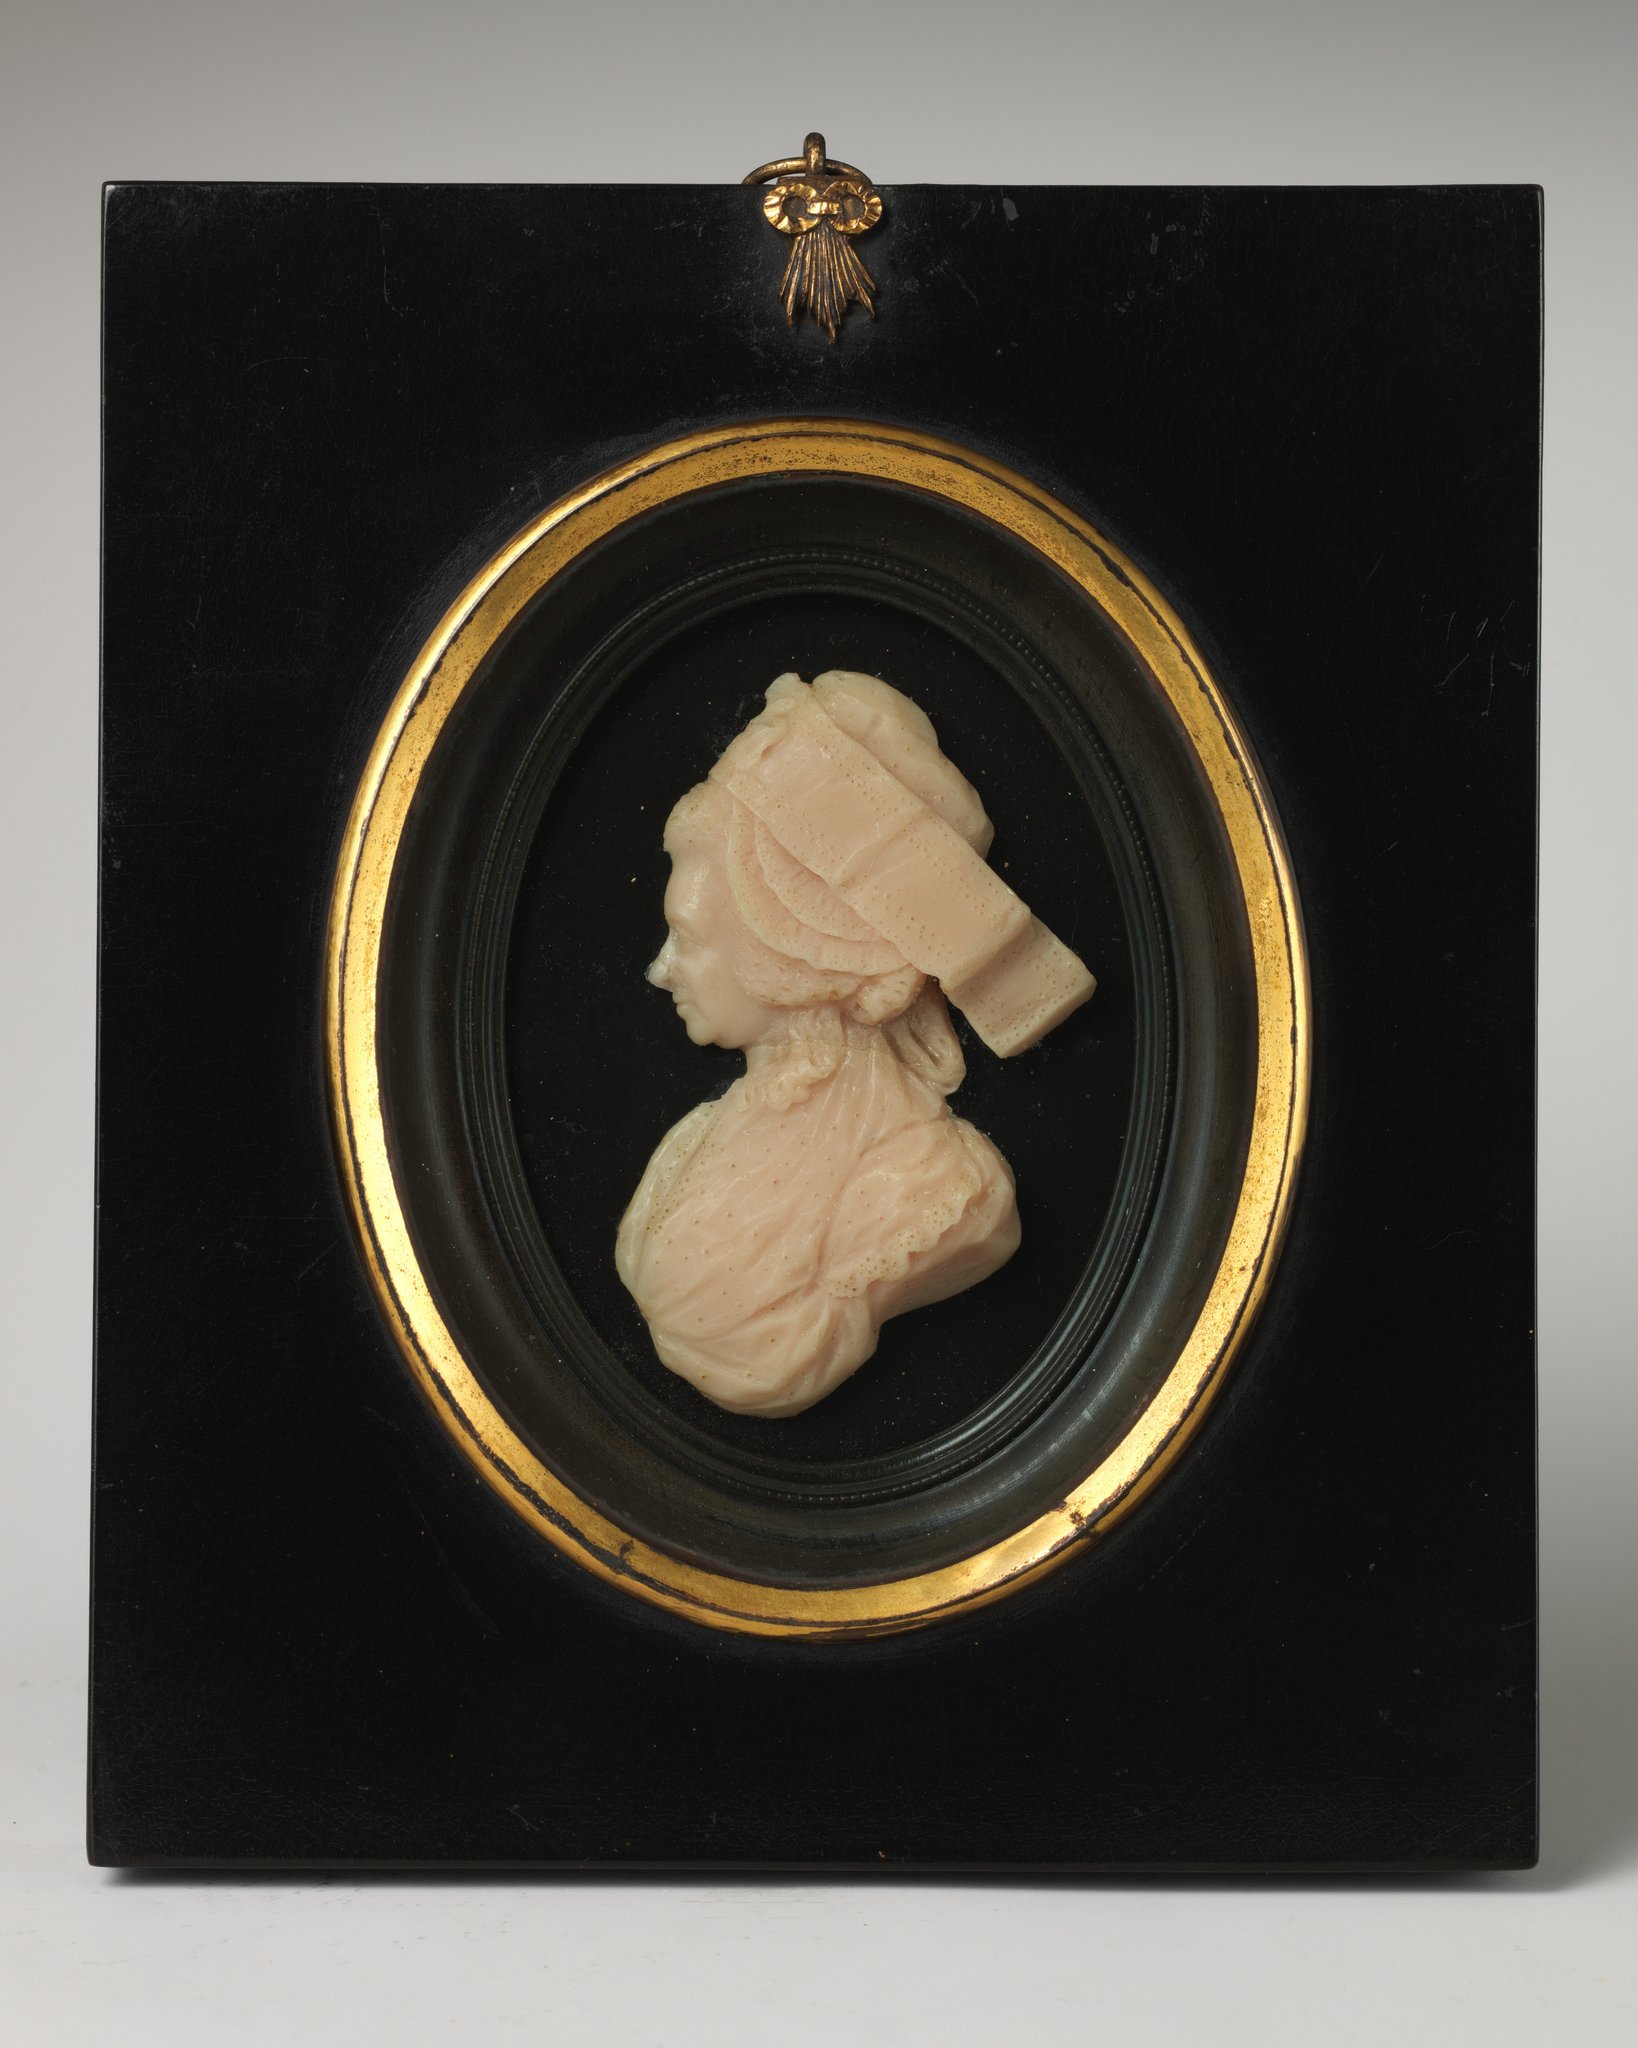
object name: medallion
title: Mrs. William Power (née Shed)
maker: john henderson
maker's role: artist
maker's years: 1729-1829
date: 1801-1900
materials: brass, glass, wax, wood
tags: profiles,women